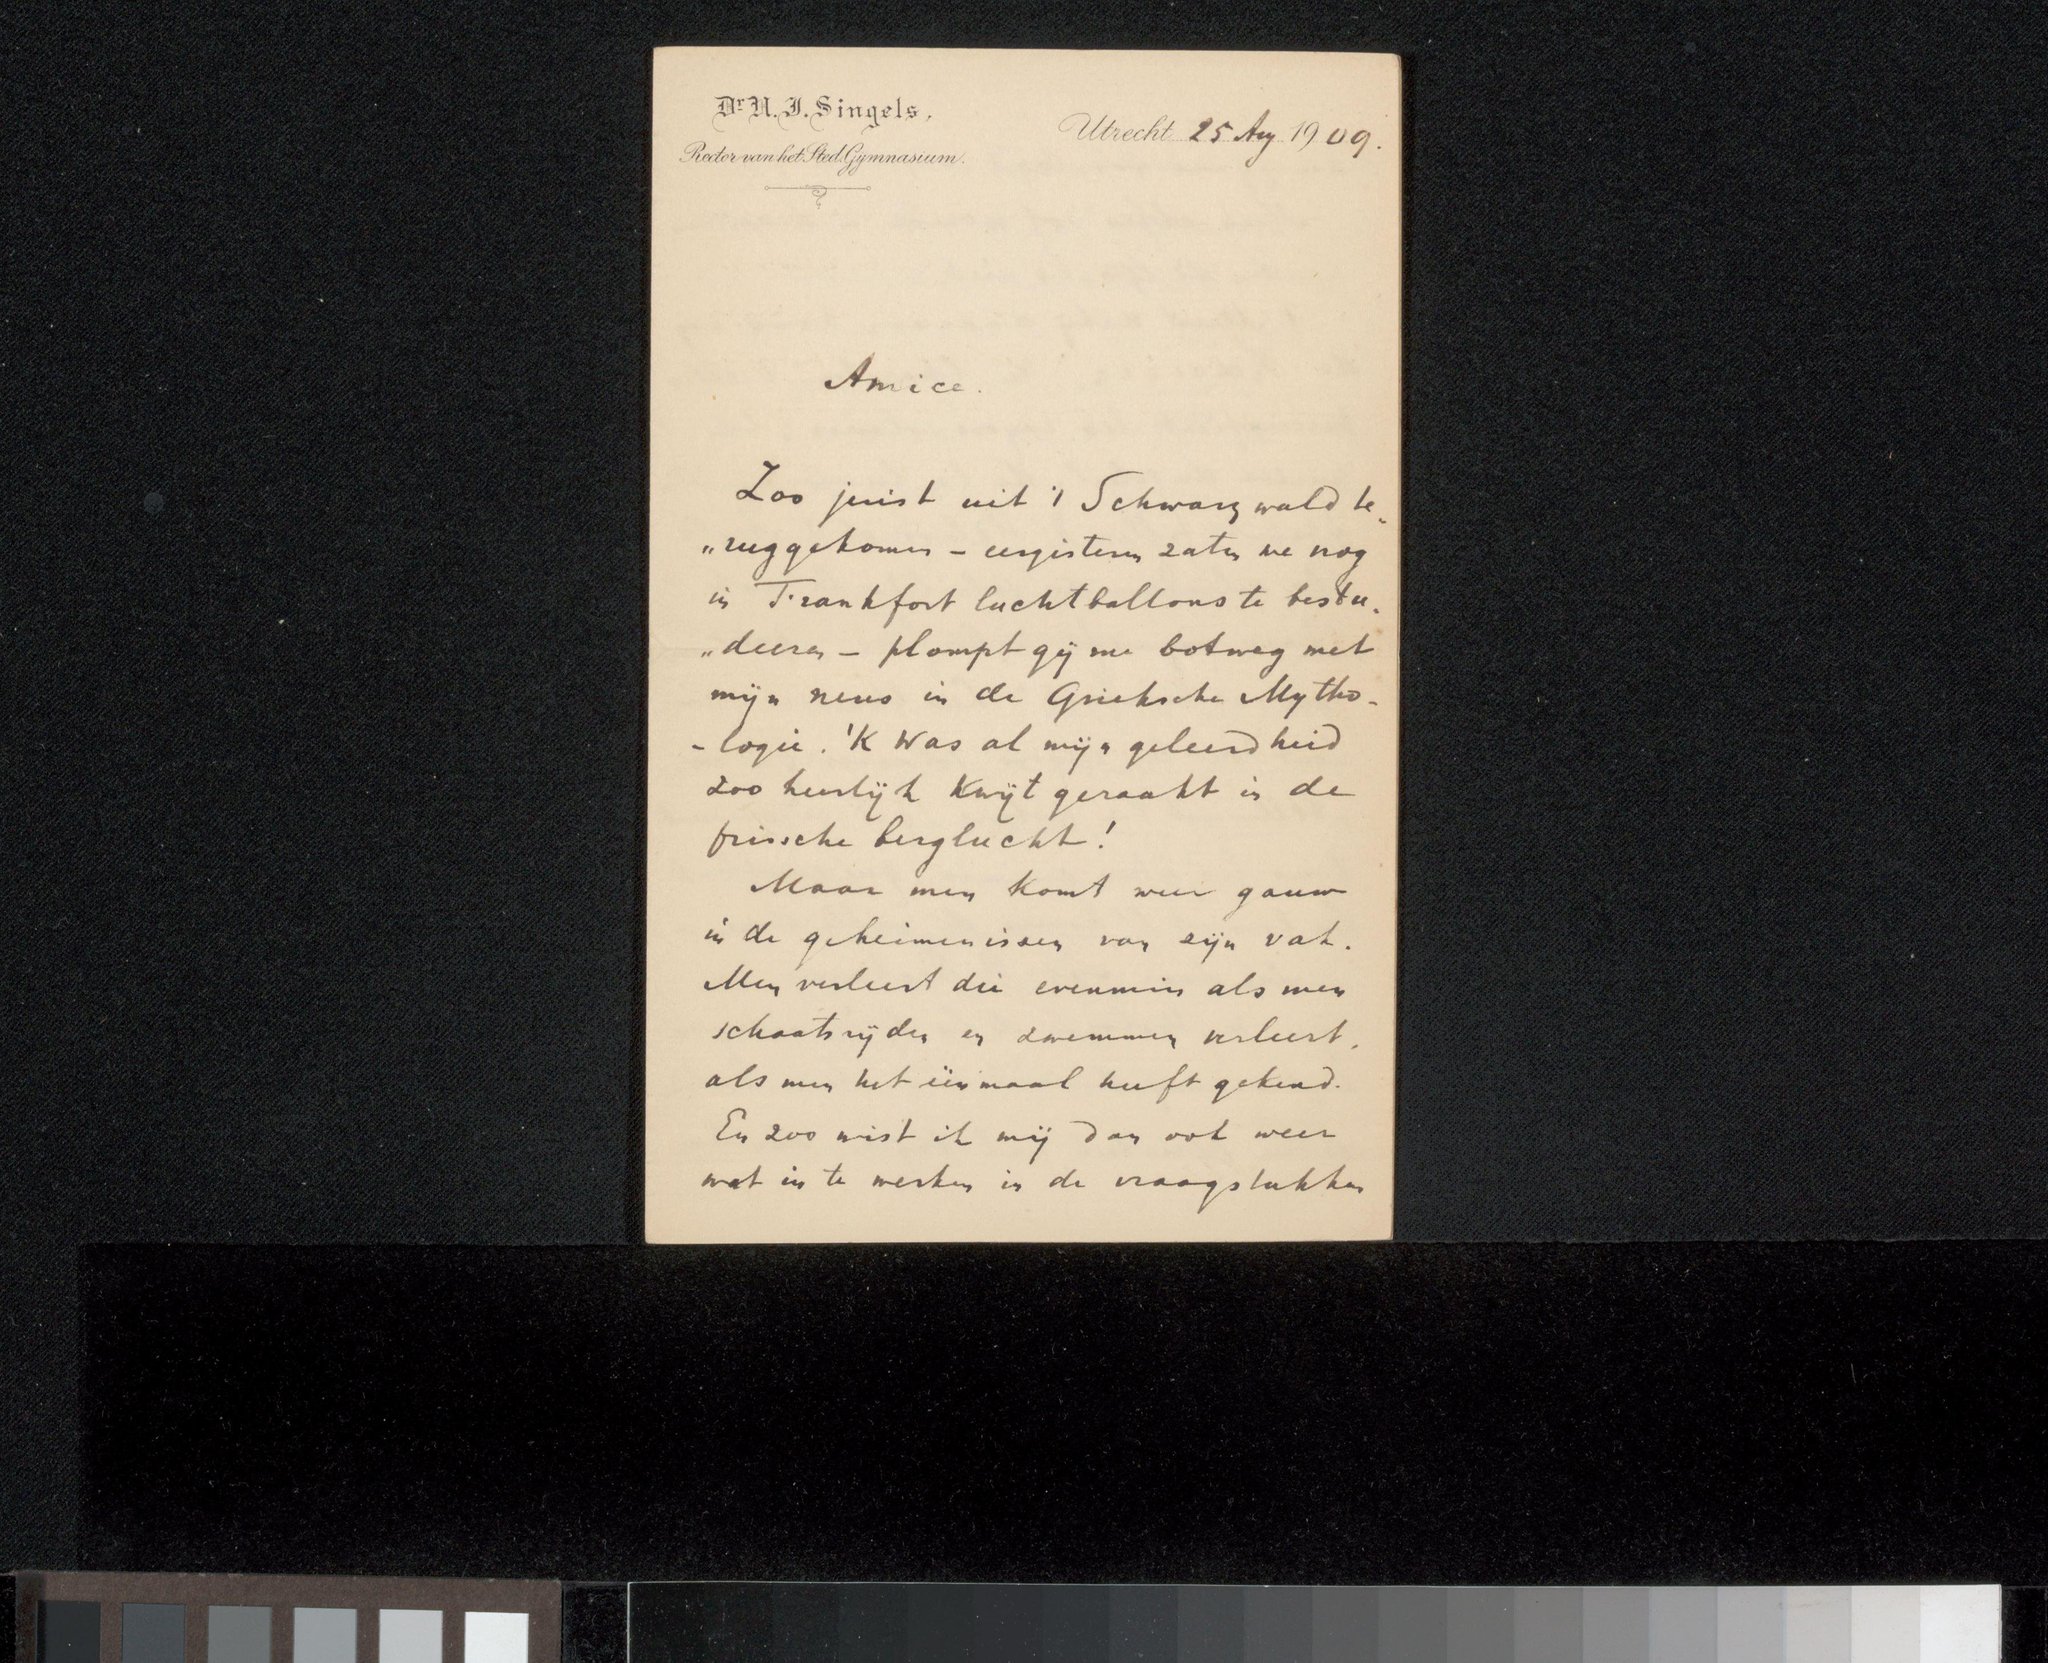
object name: letter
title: Brief aan Philip Zilcken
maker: n.j. singels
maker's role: leraar, schrijver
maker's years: 1857-1931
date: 1909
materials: ink, paper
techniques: pen, printing, writing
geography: utrecht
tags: london, the hague, painter, philip zilcken, literature ~ arts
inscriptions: collector's mark: ‘RPK’